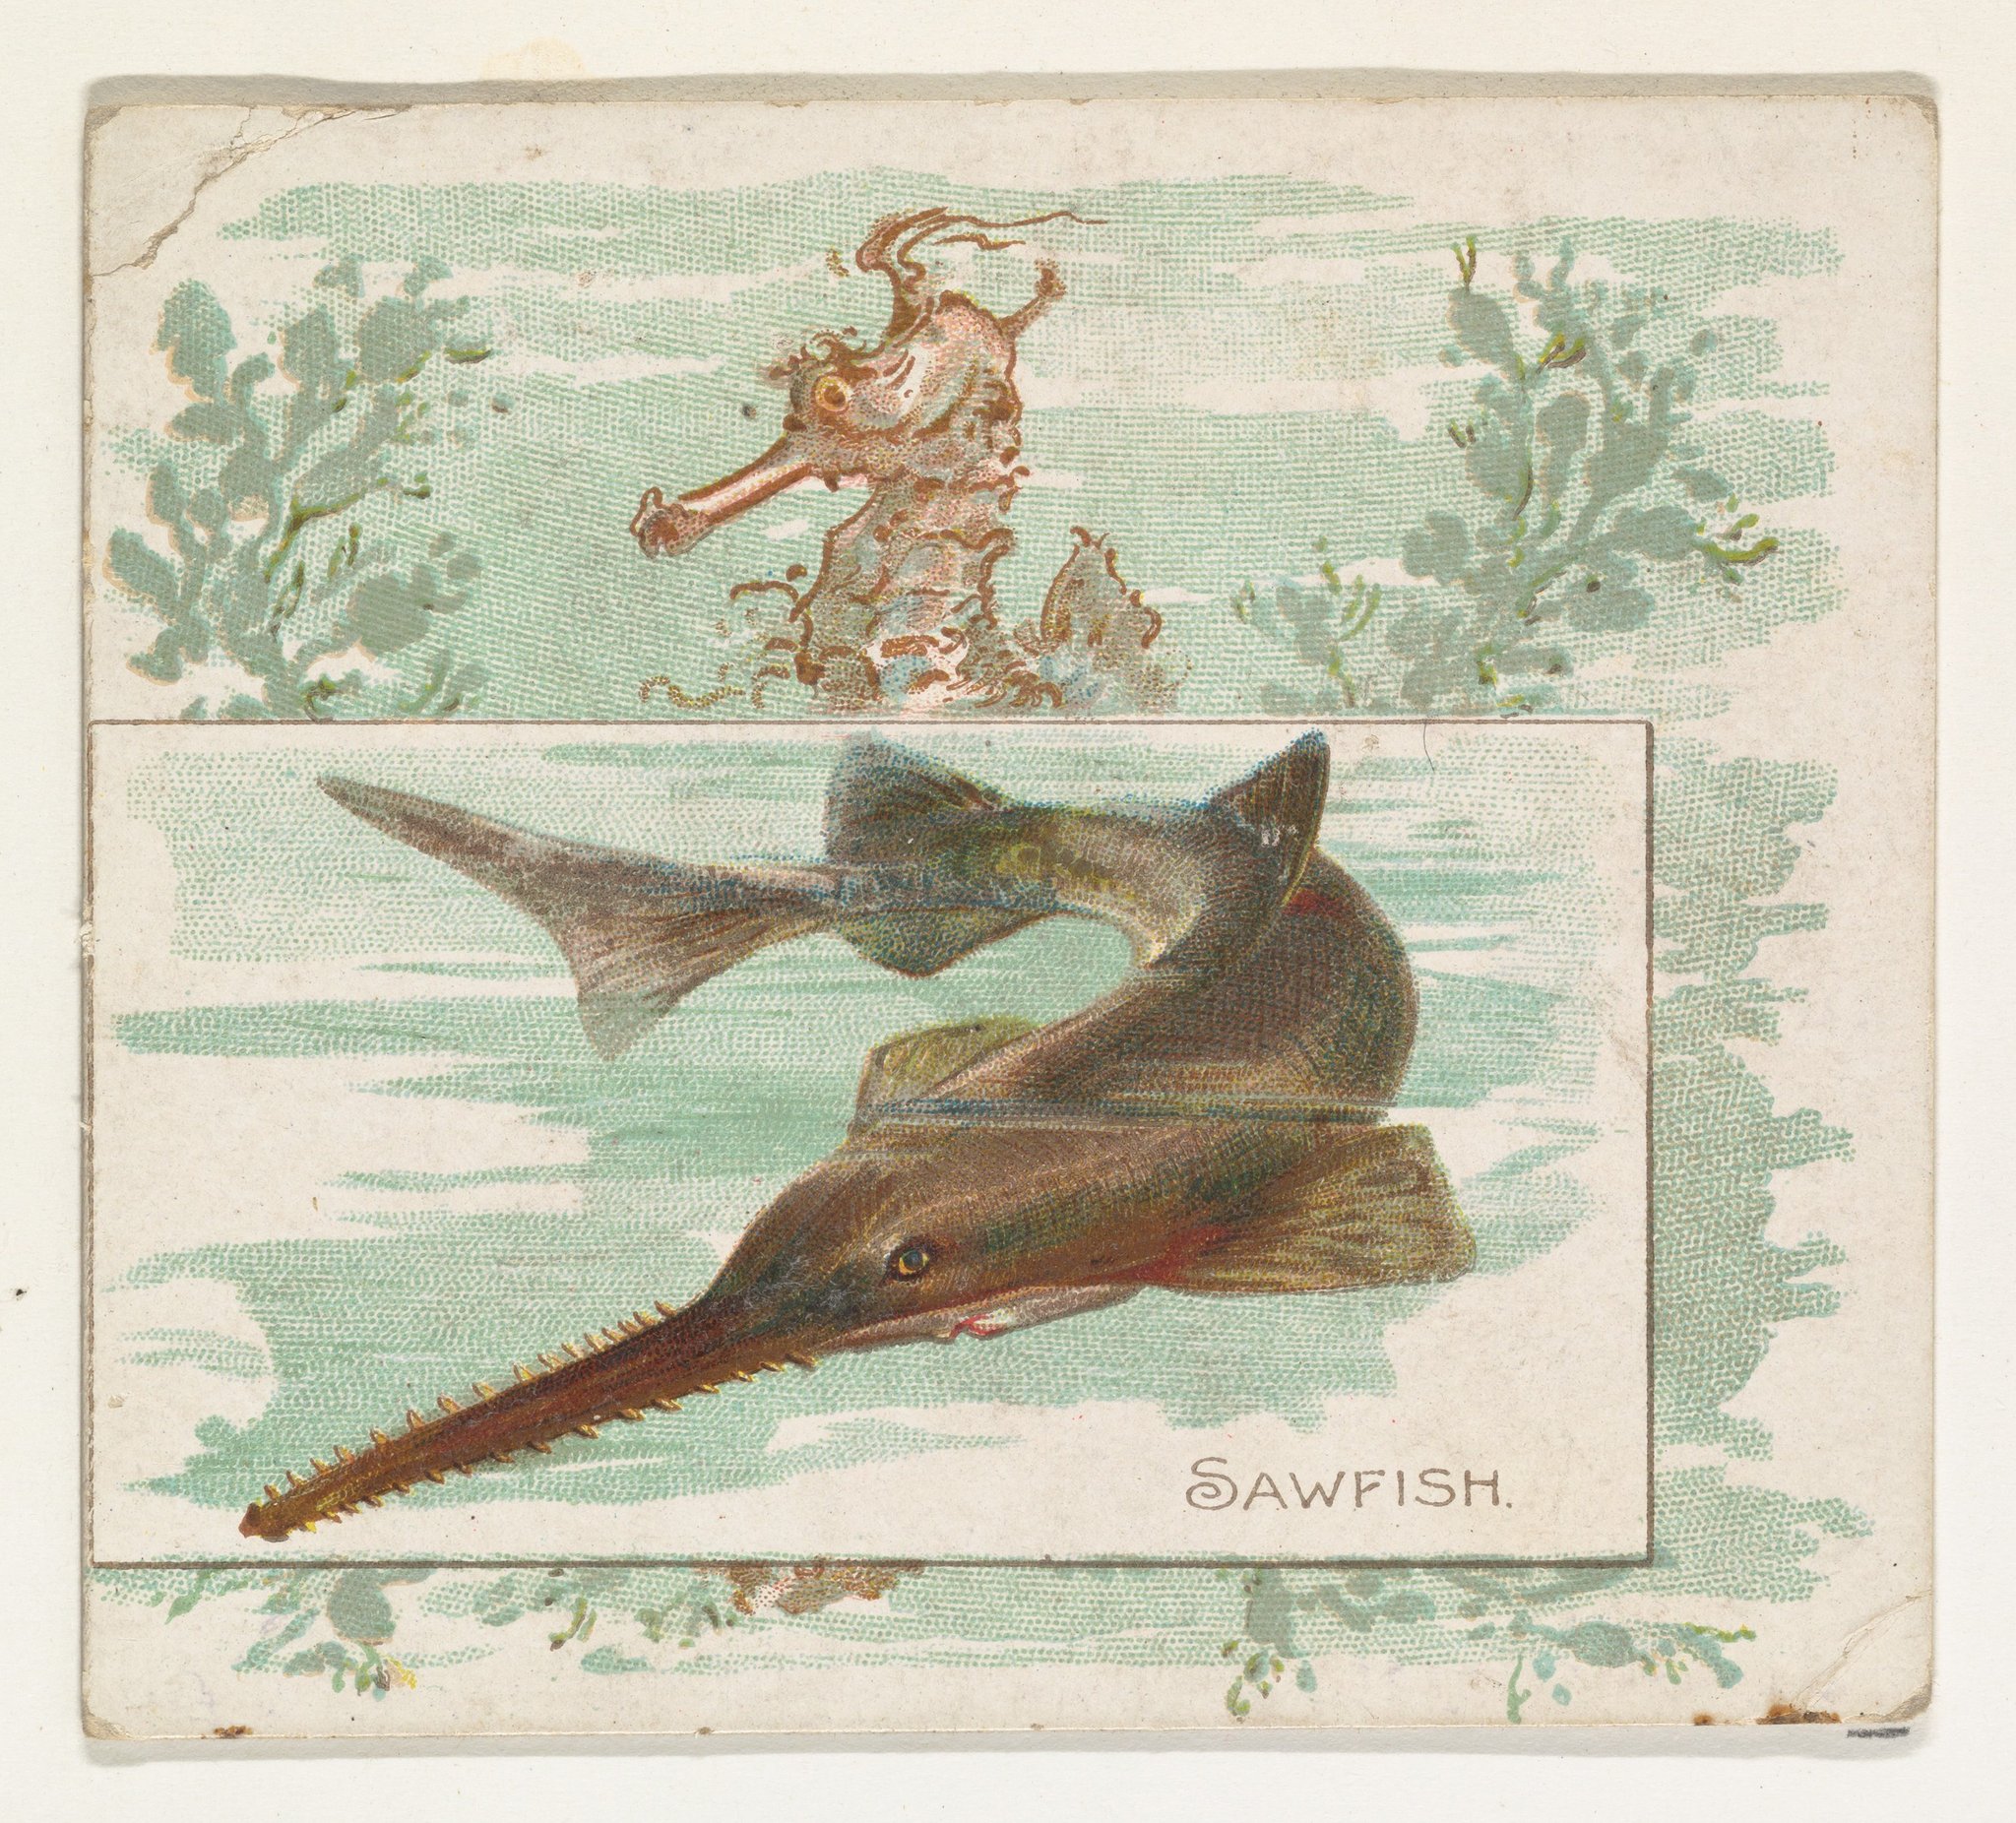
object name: print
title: Sawfish, from Fish from American Waters series (N39) for Allen & Ginter Cigarettes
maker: allen & ginter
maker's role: publisher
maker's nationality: american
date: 1889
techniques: color lithograph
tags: fish